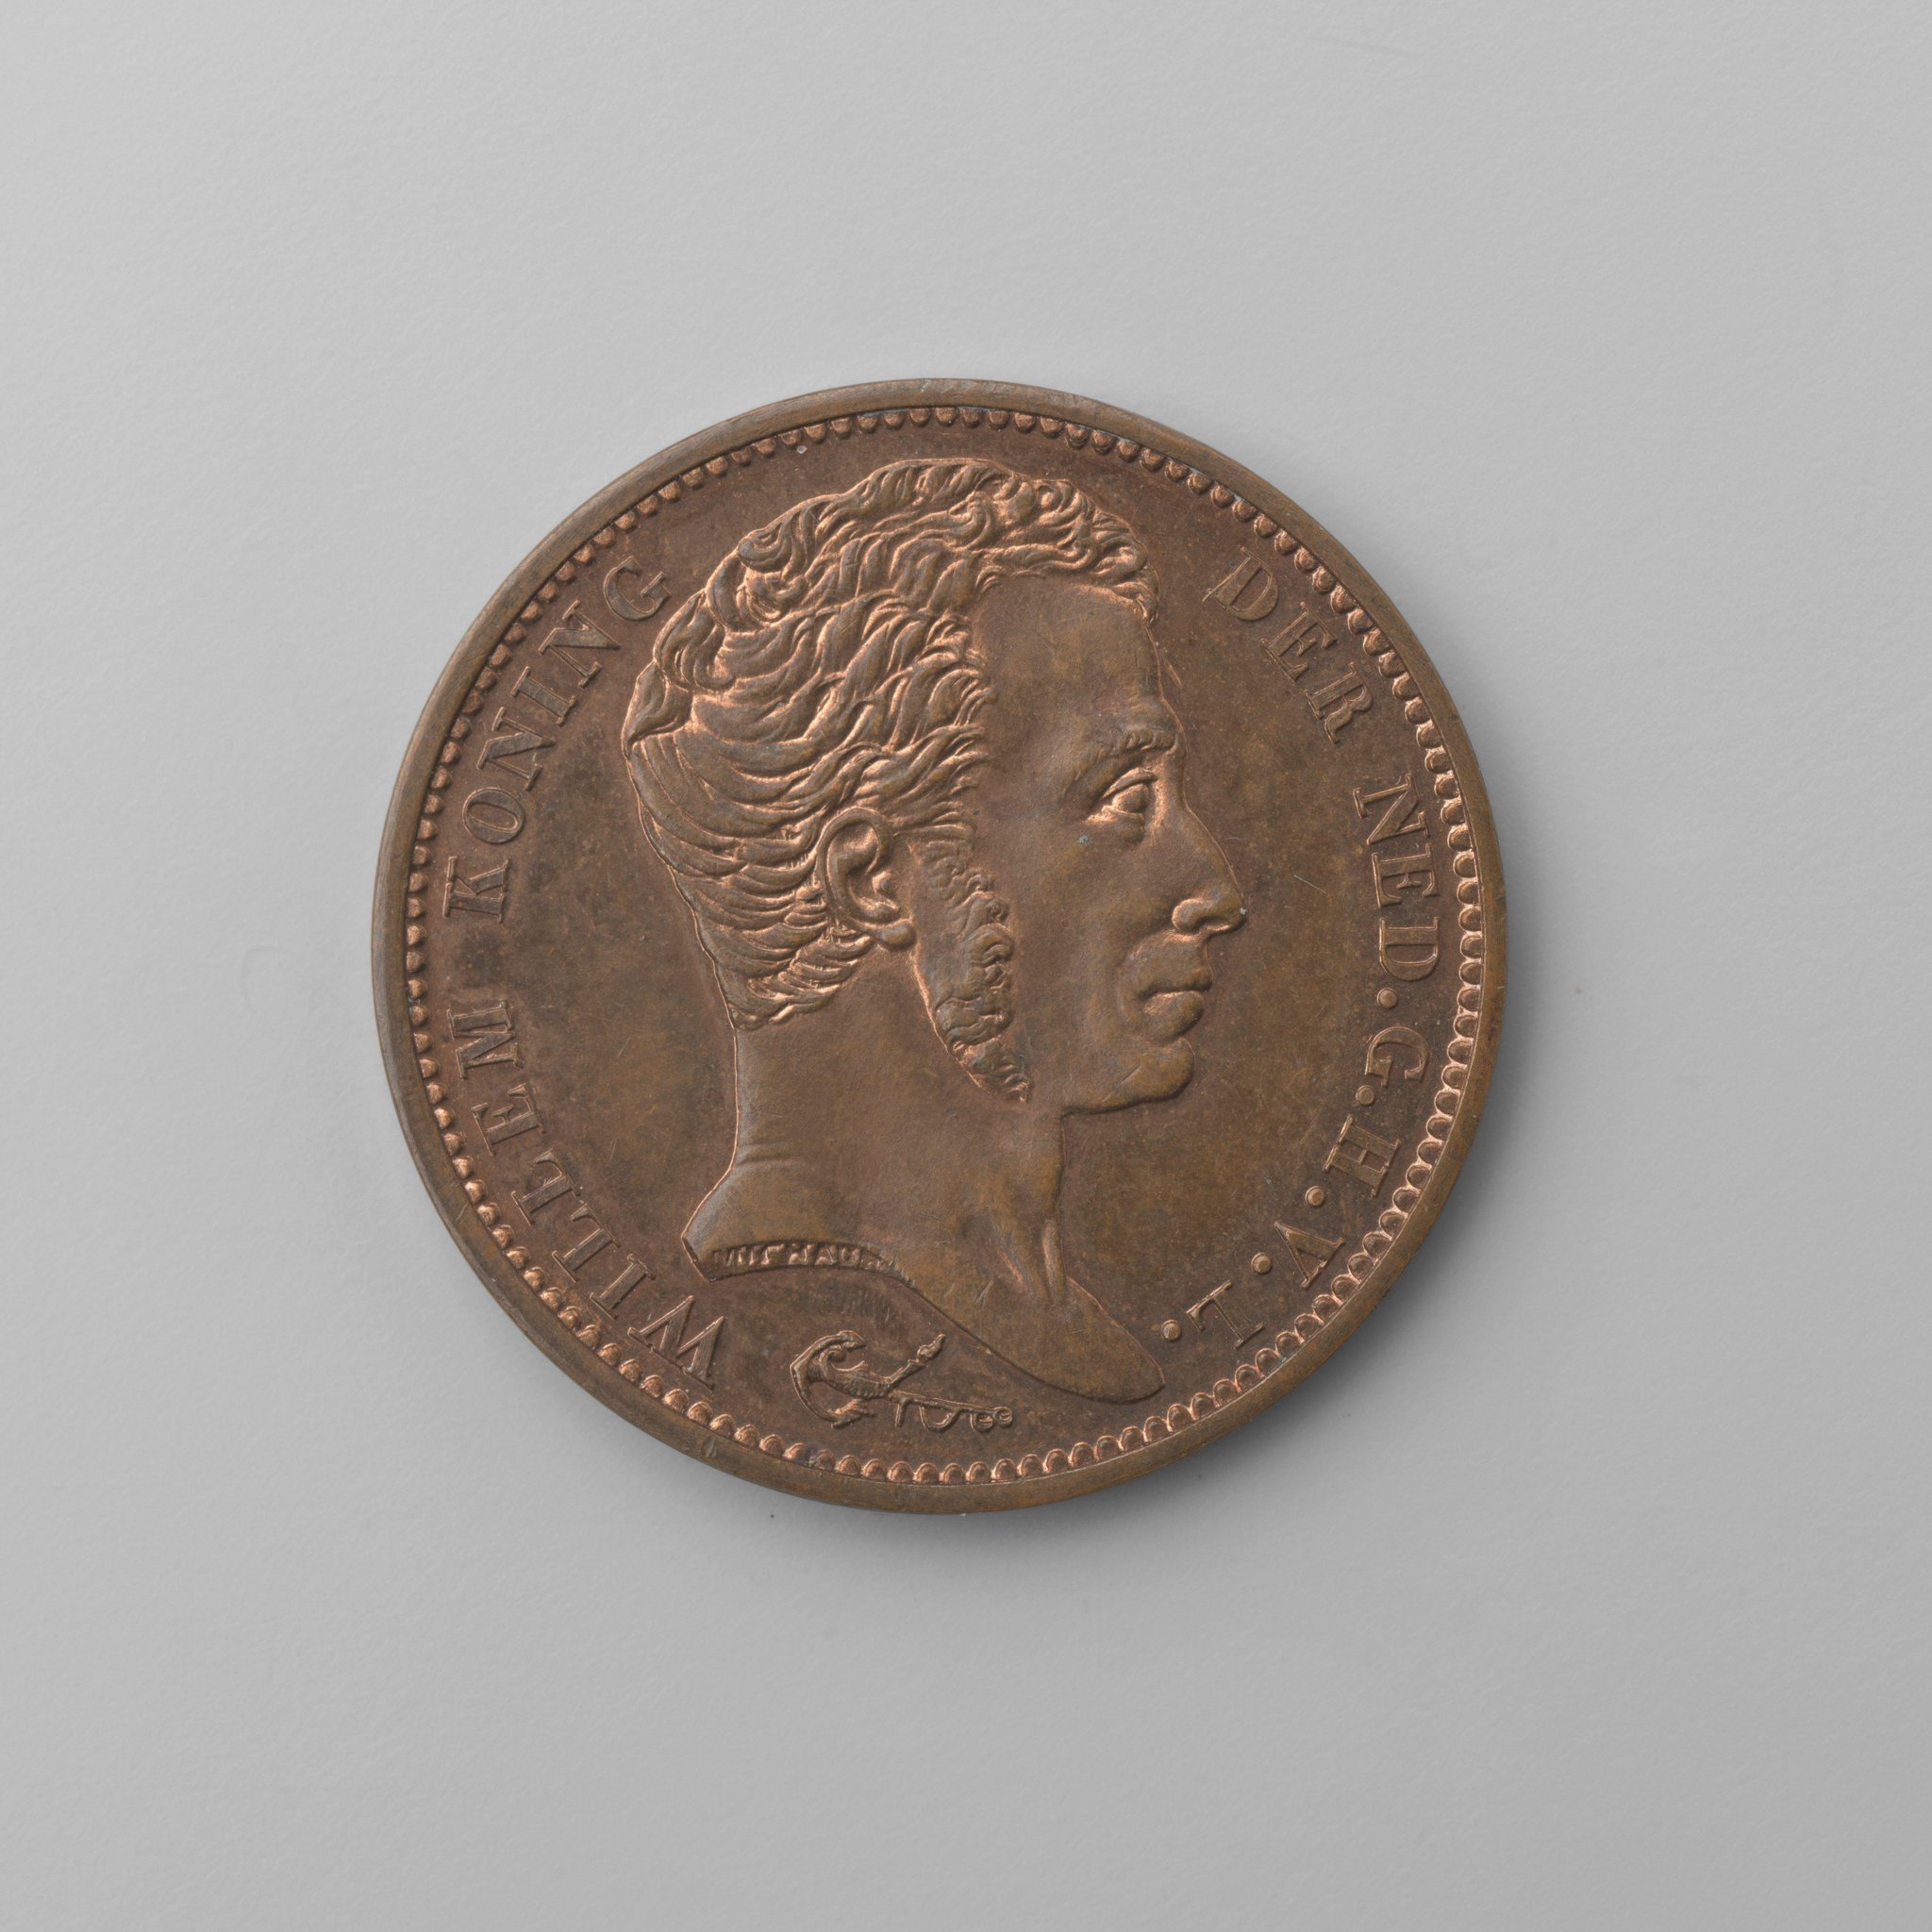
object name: coin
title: Nederland, gulden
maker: william i of the netherlands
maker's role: koning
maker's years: 1772-1843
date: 1900-1925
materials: bronze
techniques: striking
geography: utrecht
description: Bronzen identiteitspenning uit begin van de twintigste eeuw. Voorzijde: borstbeeld van koning Willem I naar rechts. Keerzijde: gladde muntplaat, waarin ingeslagen een mercuriusstaf en nummer 31.Gladde rand.